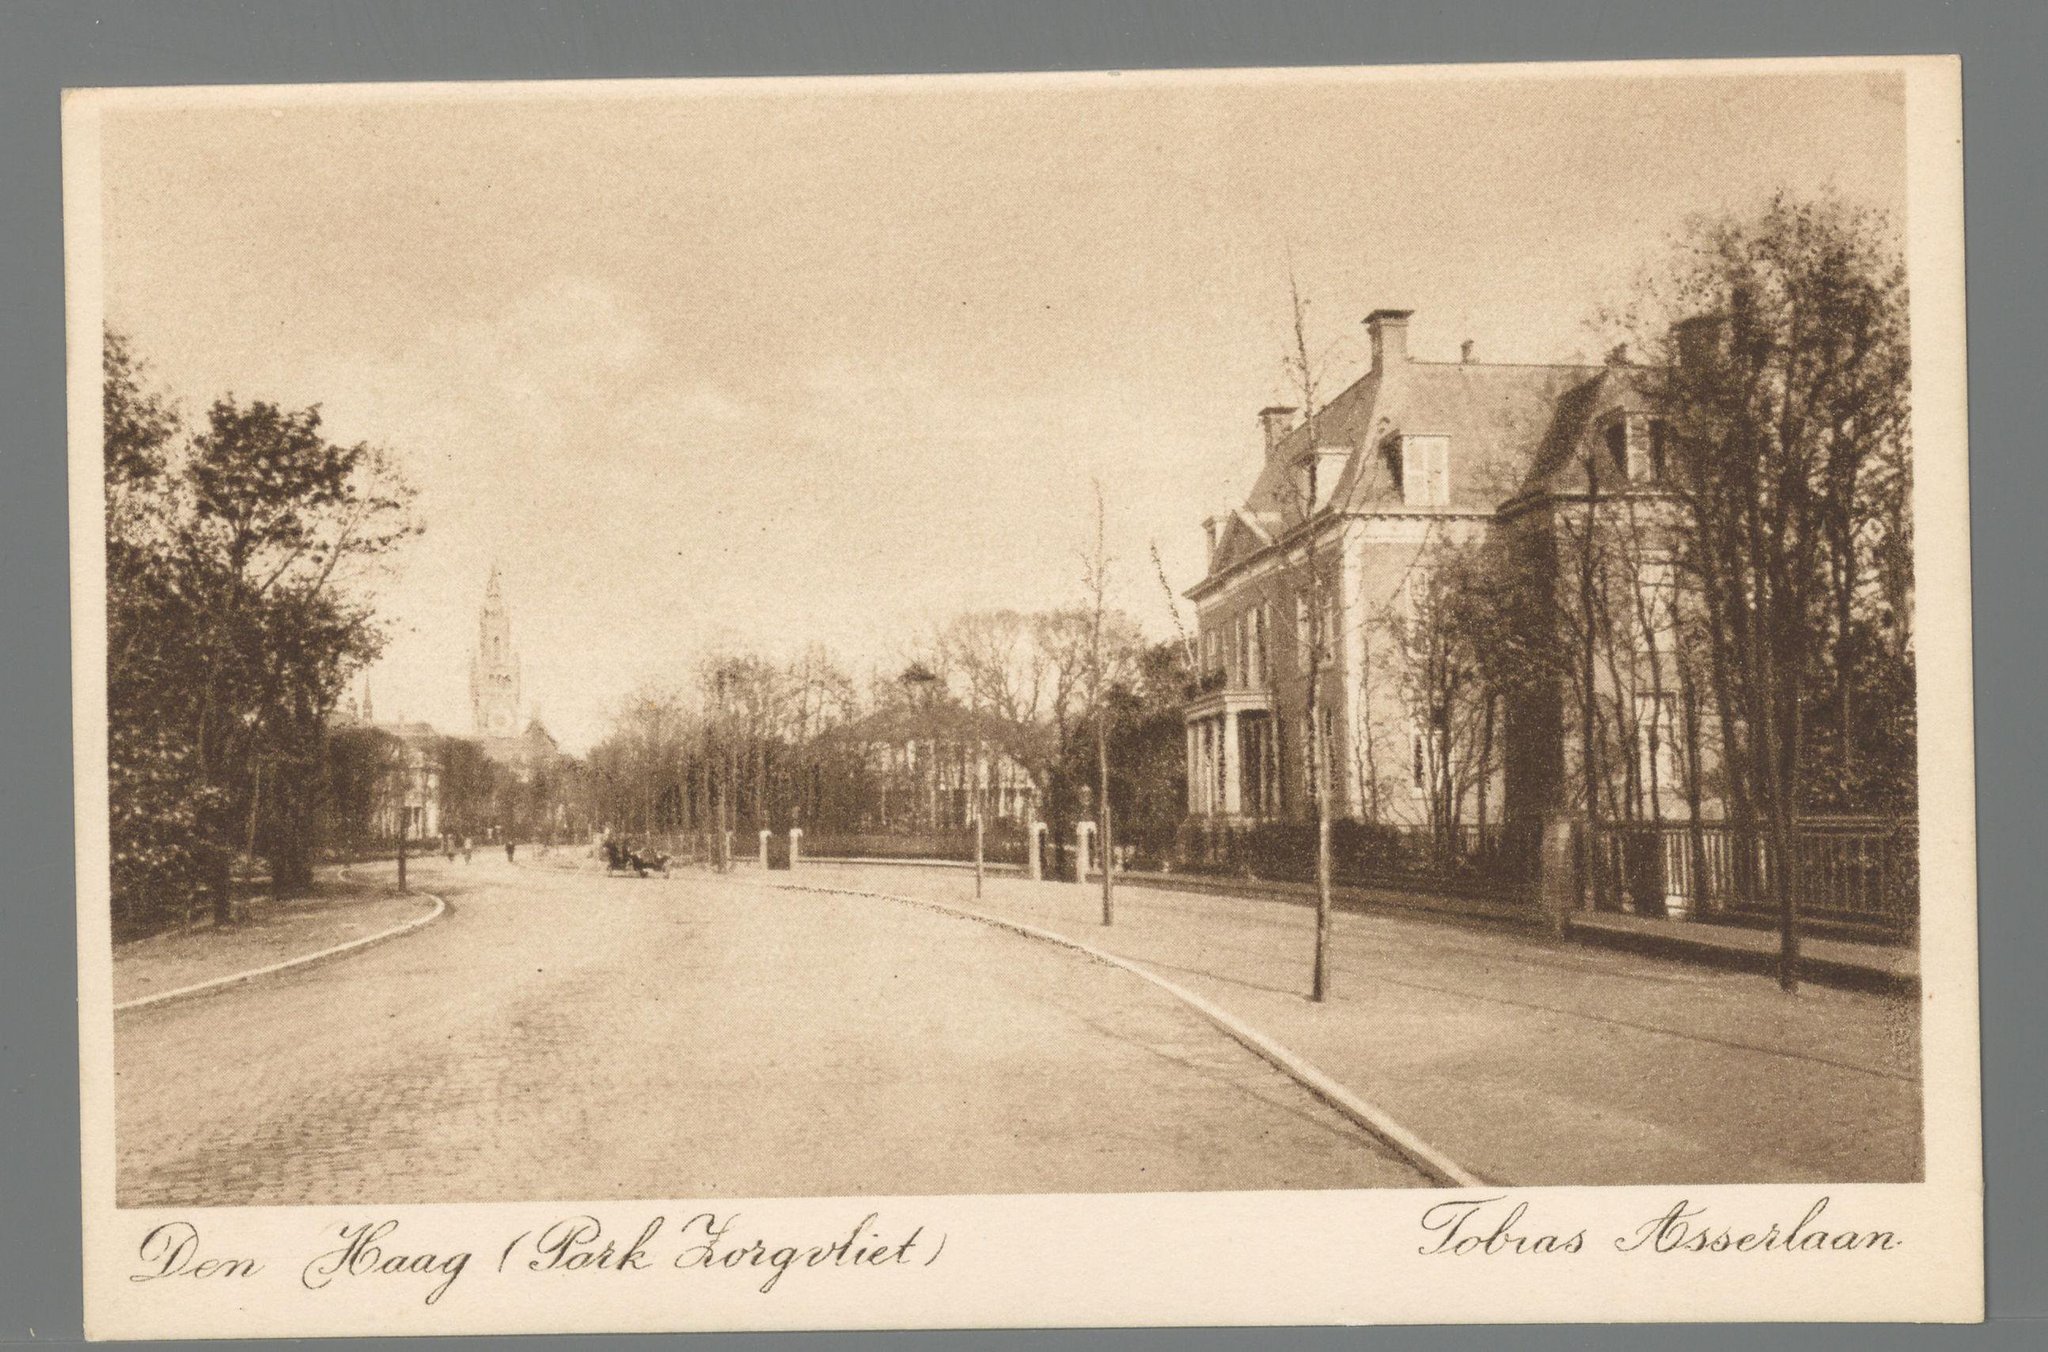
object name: ansichtkaart, prentbriefkaart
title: Tobias Asserlaan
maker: Anonymous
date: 1913-1930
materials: cardboard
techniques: rotogravure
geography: the hague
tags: park, street